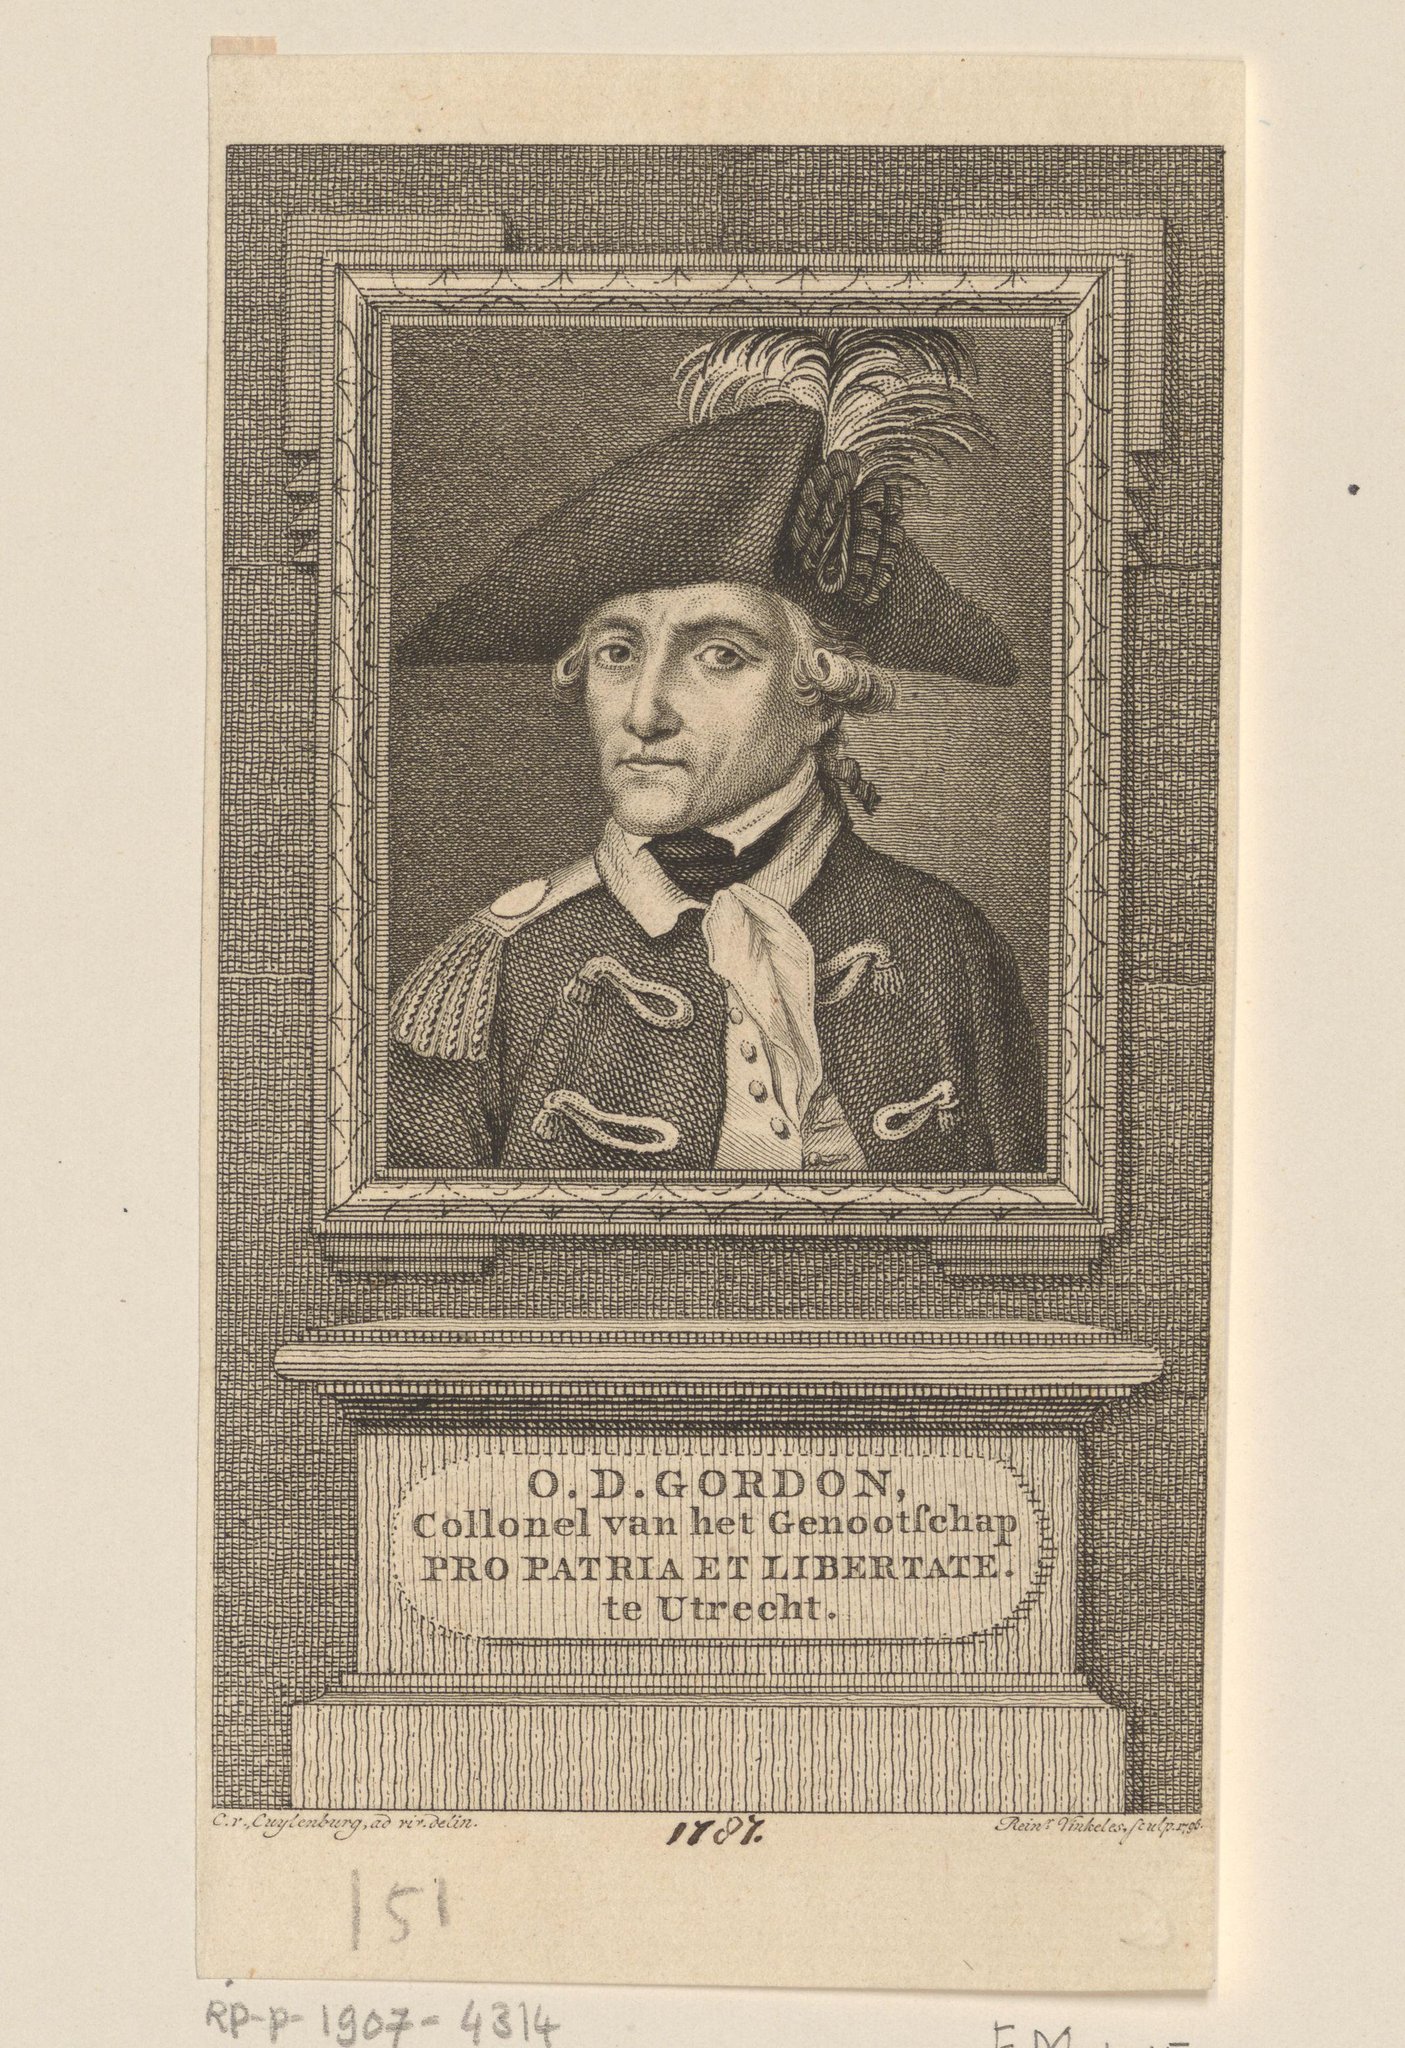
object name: print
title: Portret van Otto Derk Gordon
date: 1796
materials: paper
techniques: engraving, etching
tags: utrecht, otto derk gordon, historical persons, officer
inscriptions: collector's mark: Lugt 2228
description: Tekst in het Nederlands in de ondermarge.